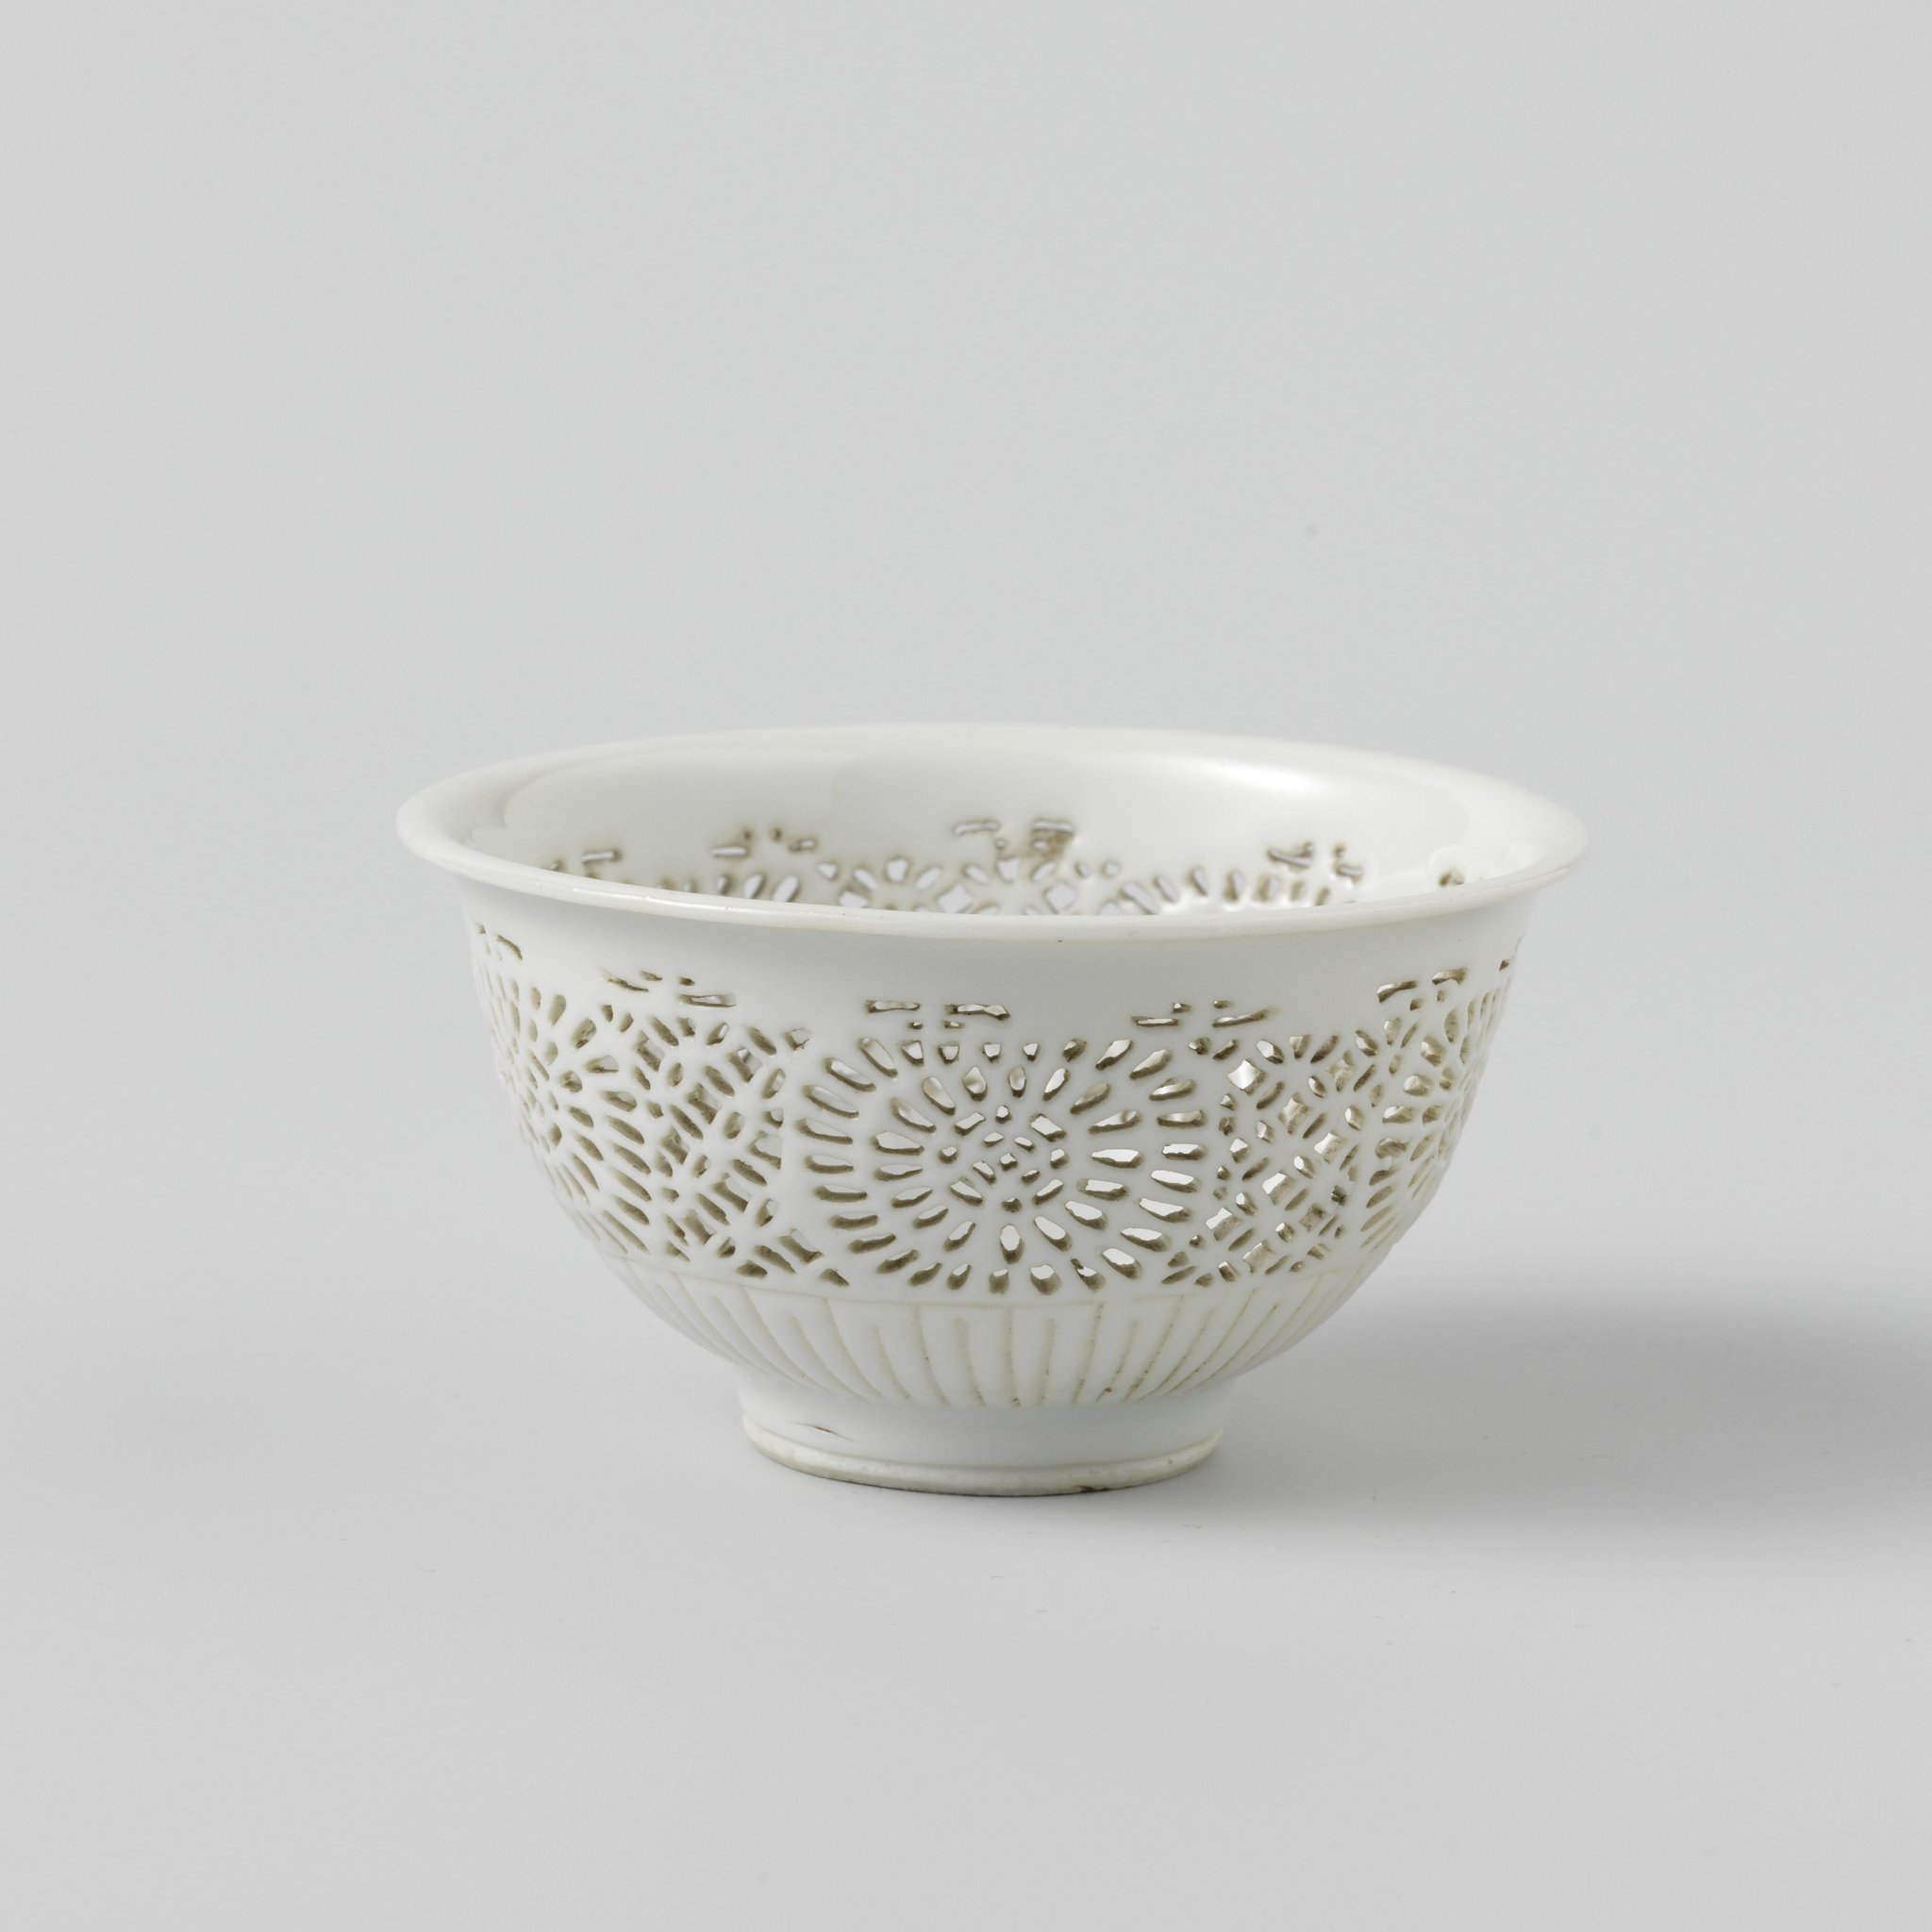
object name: bowl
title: White bowl with pierced sides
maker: Anonymous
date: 1625-1649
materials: glaze, porcelain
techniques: embroidery, firing, turning, vitrification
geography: china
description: Kom van porselein met opengewerkte wand en spreidende rand, bedekt met een doorschijnend wit glazuur. De wand met een band ajourwerk met vijf rozetten; rond de voet een band met ingegrifde lijnen. Onderzijde ongeglazuurd. Overgangsporselein.